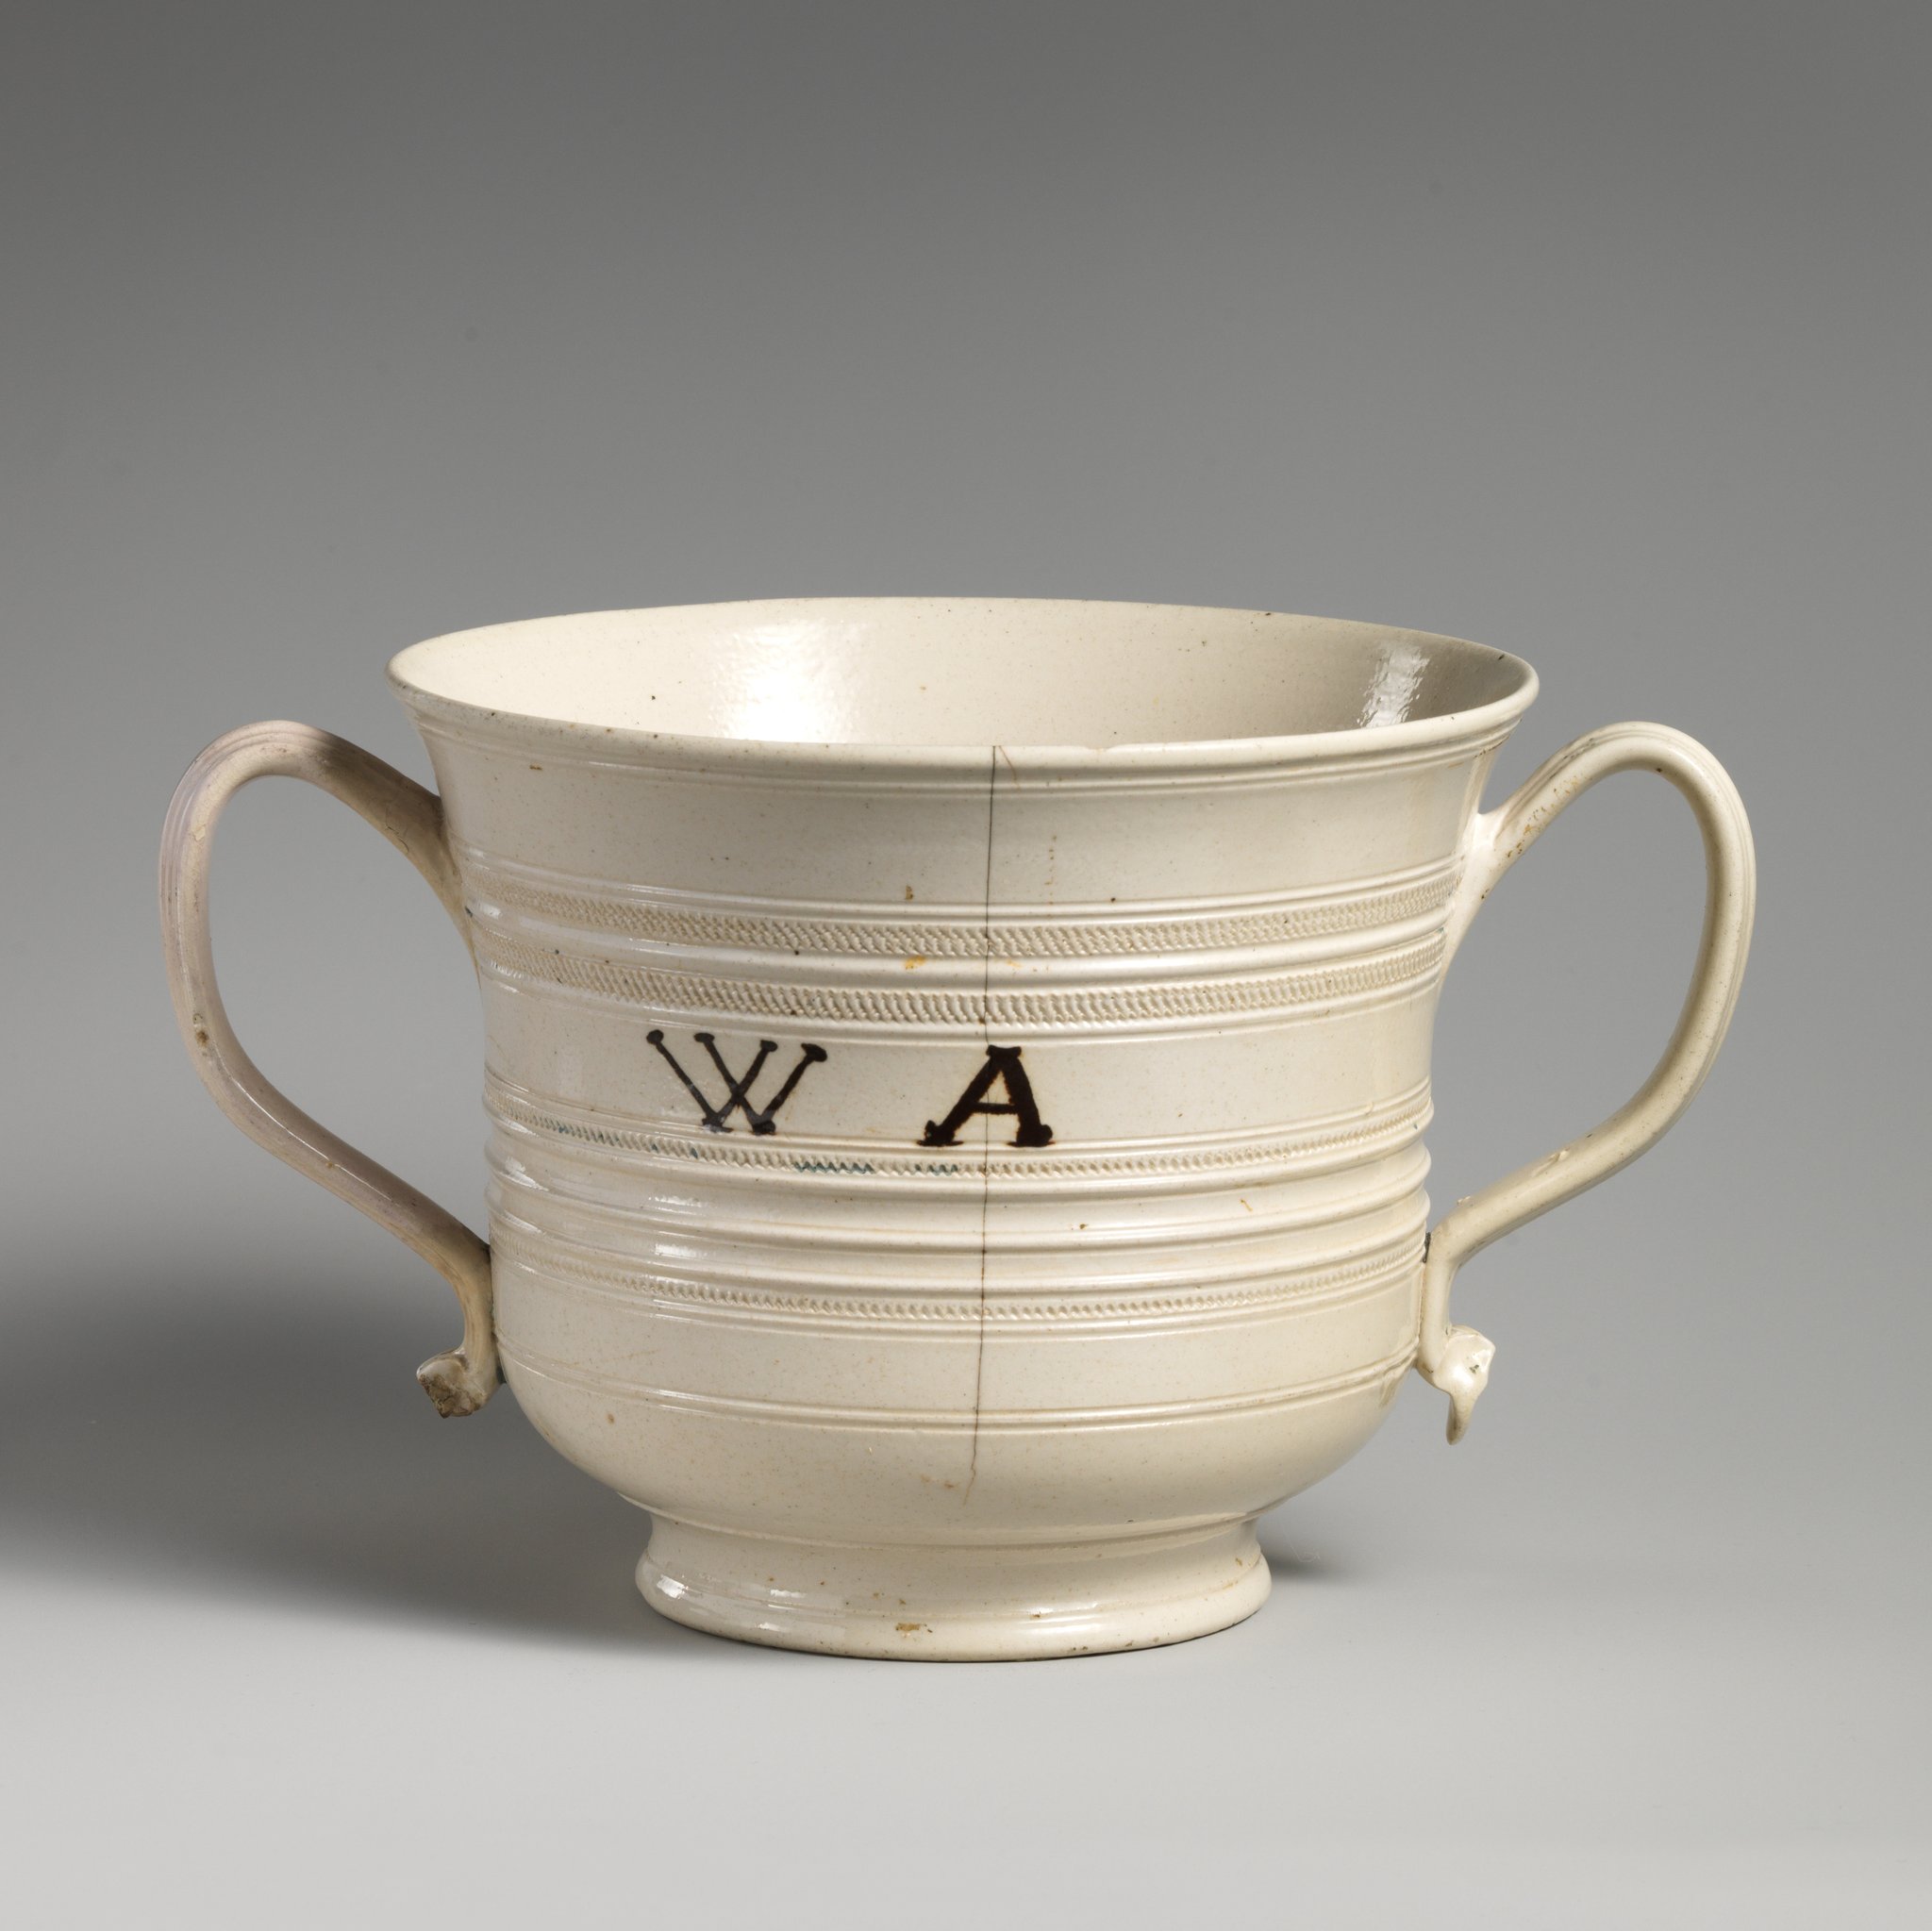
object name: loving cup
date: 1735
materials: stoneware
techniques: salt glaze